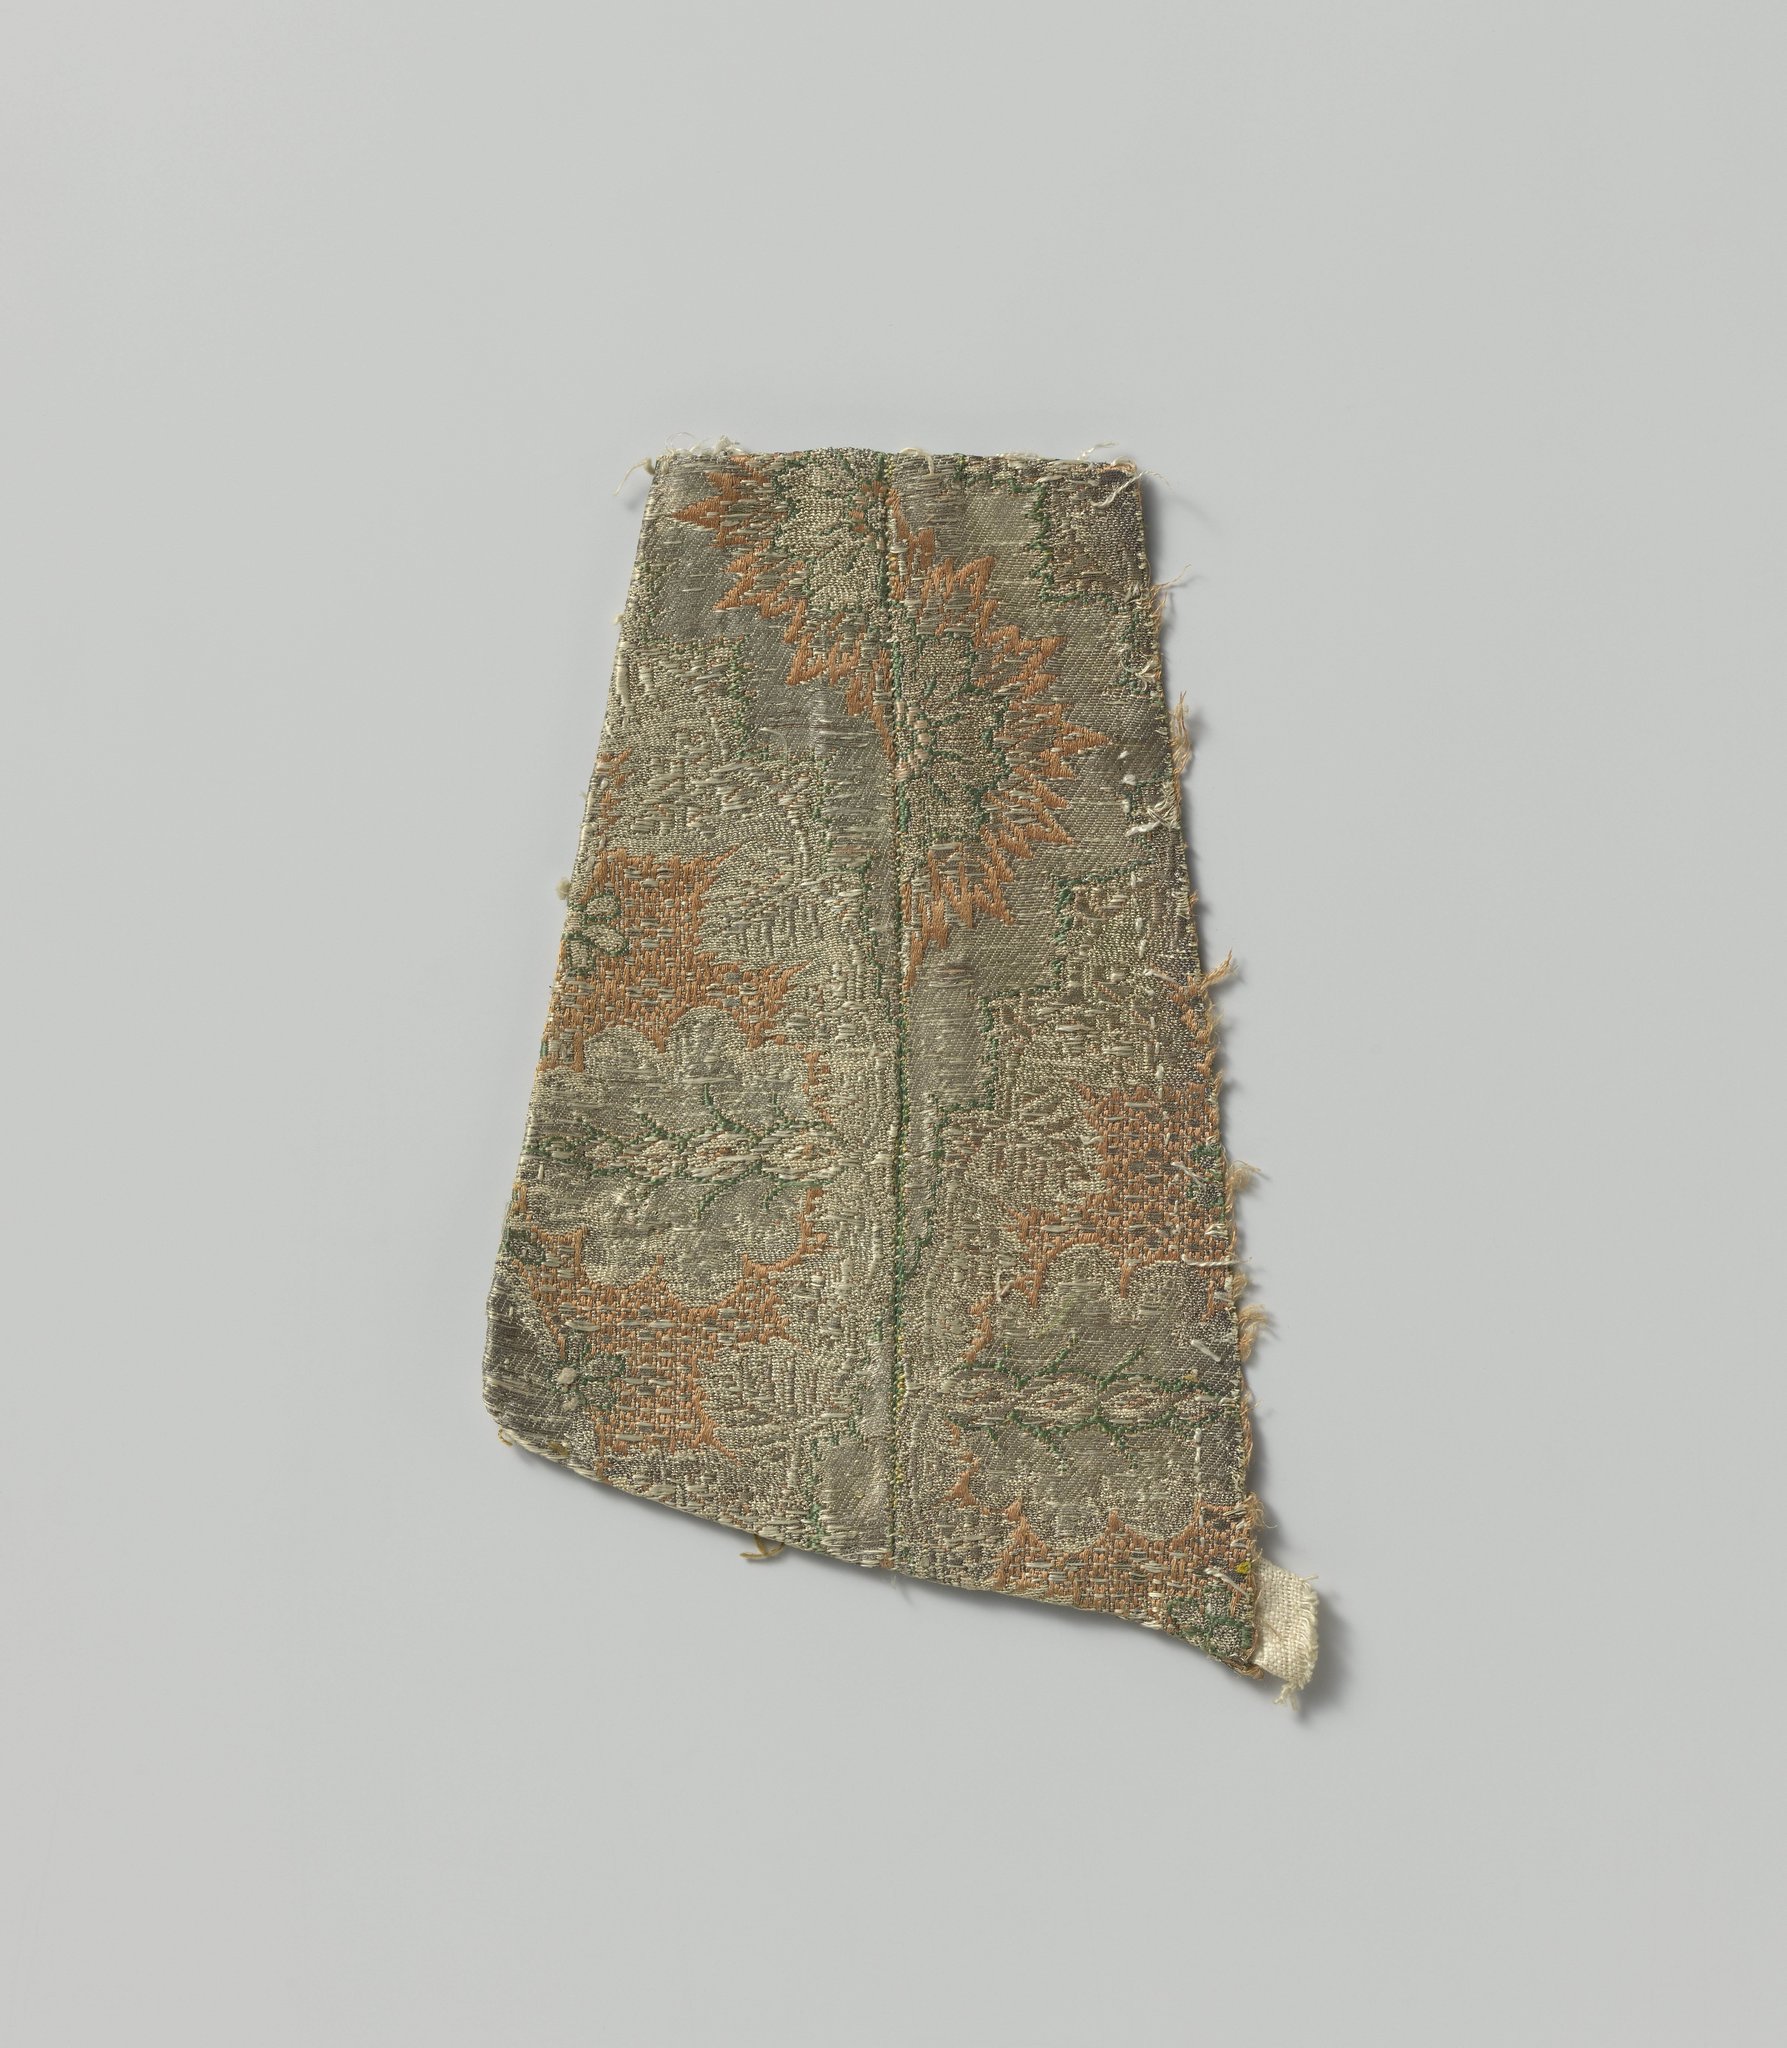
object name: fragment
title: Fragment veelkleurig brocatel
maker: Anonymous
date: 1775-1800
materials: textile, linen, metal thread, silk